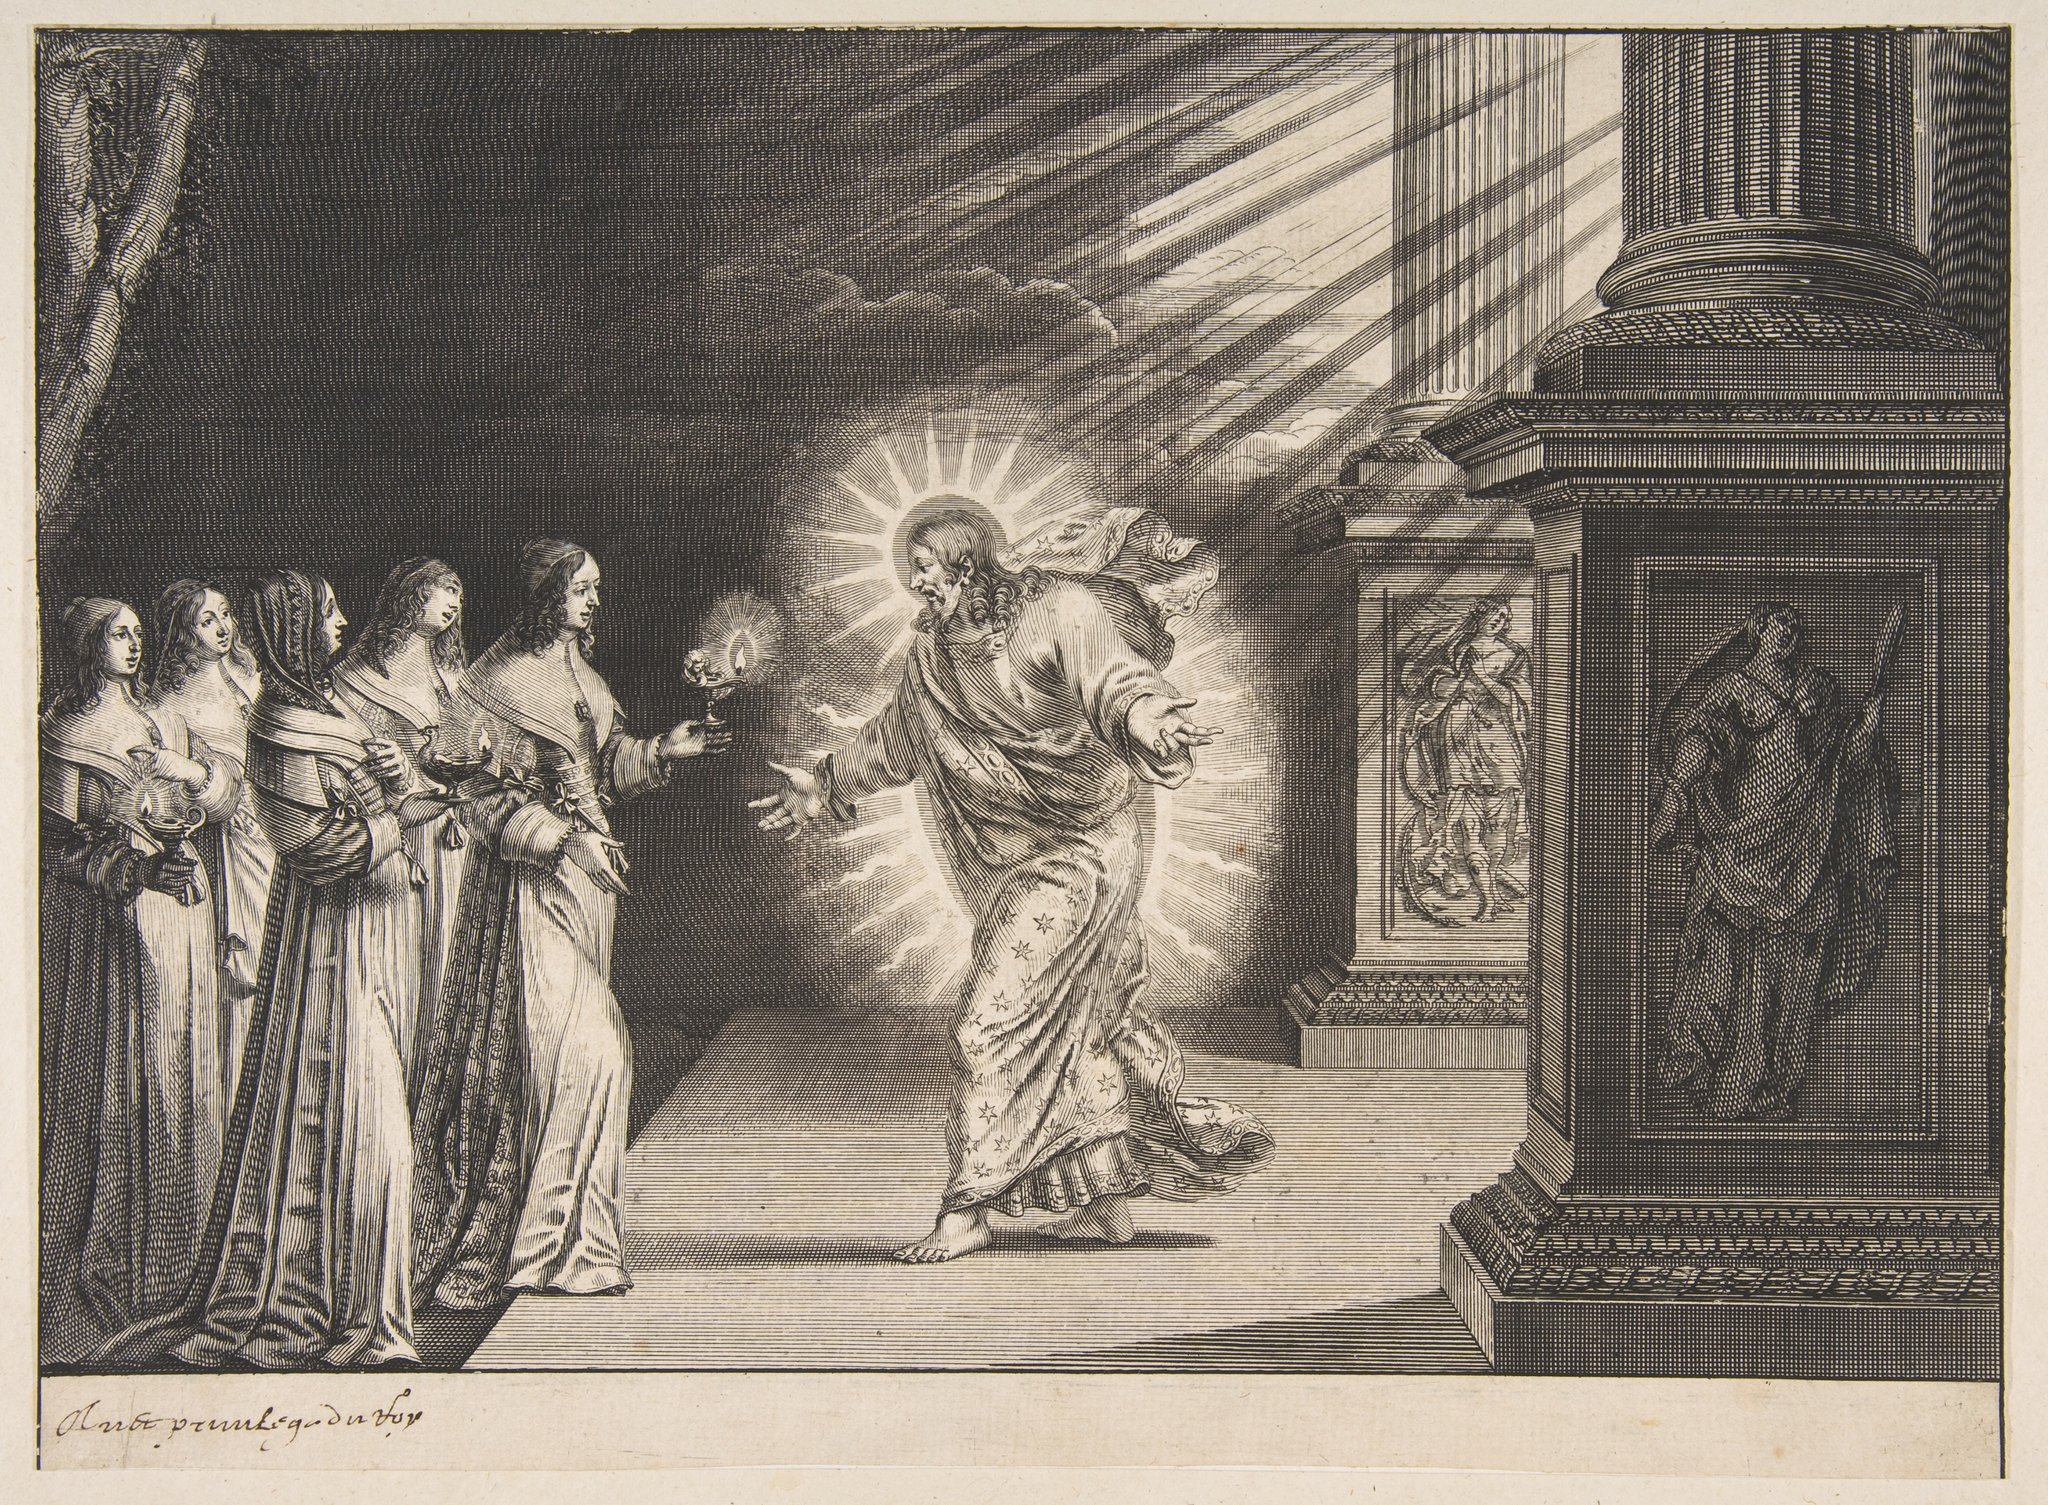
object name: print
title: The Wise Virgins before Christ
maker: abraham bosse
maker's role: artist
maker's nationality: french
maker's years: 1602-1676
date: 1635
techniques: engraving, etching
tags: women,christ